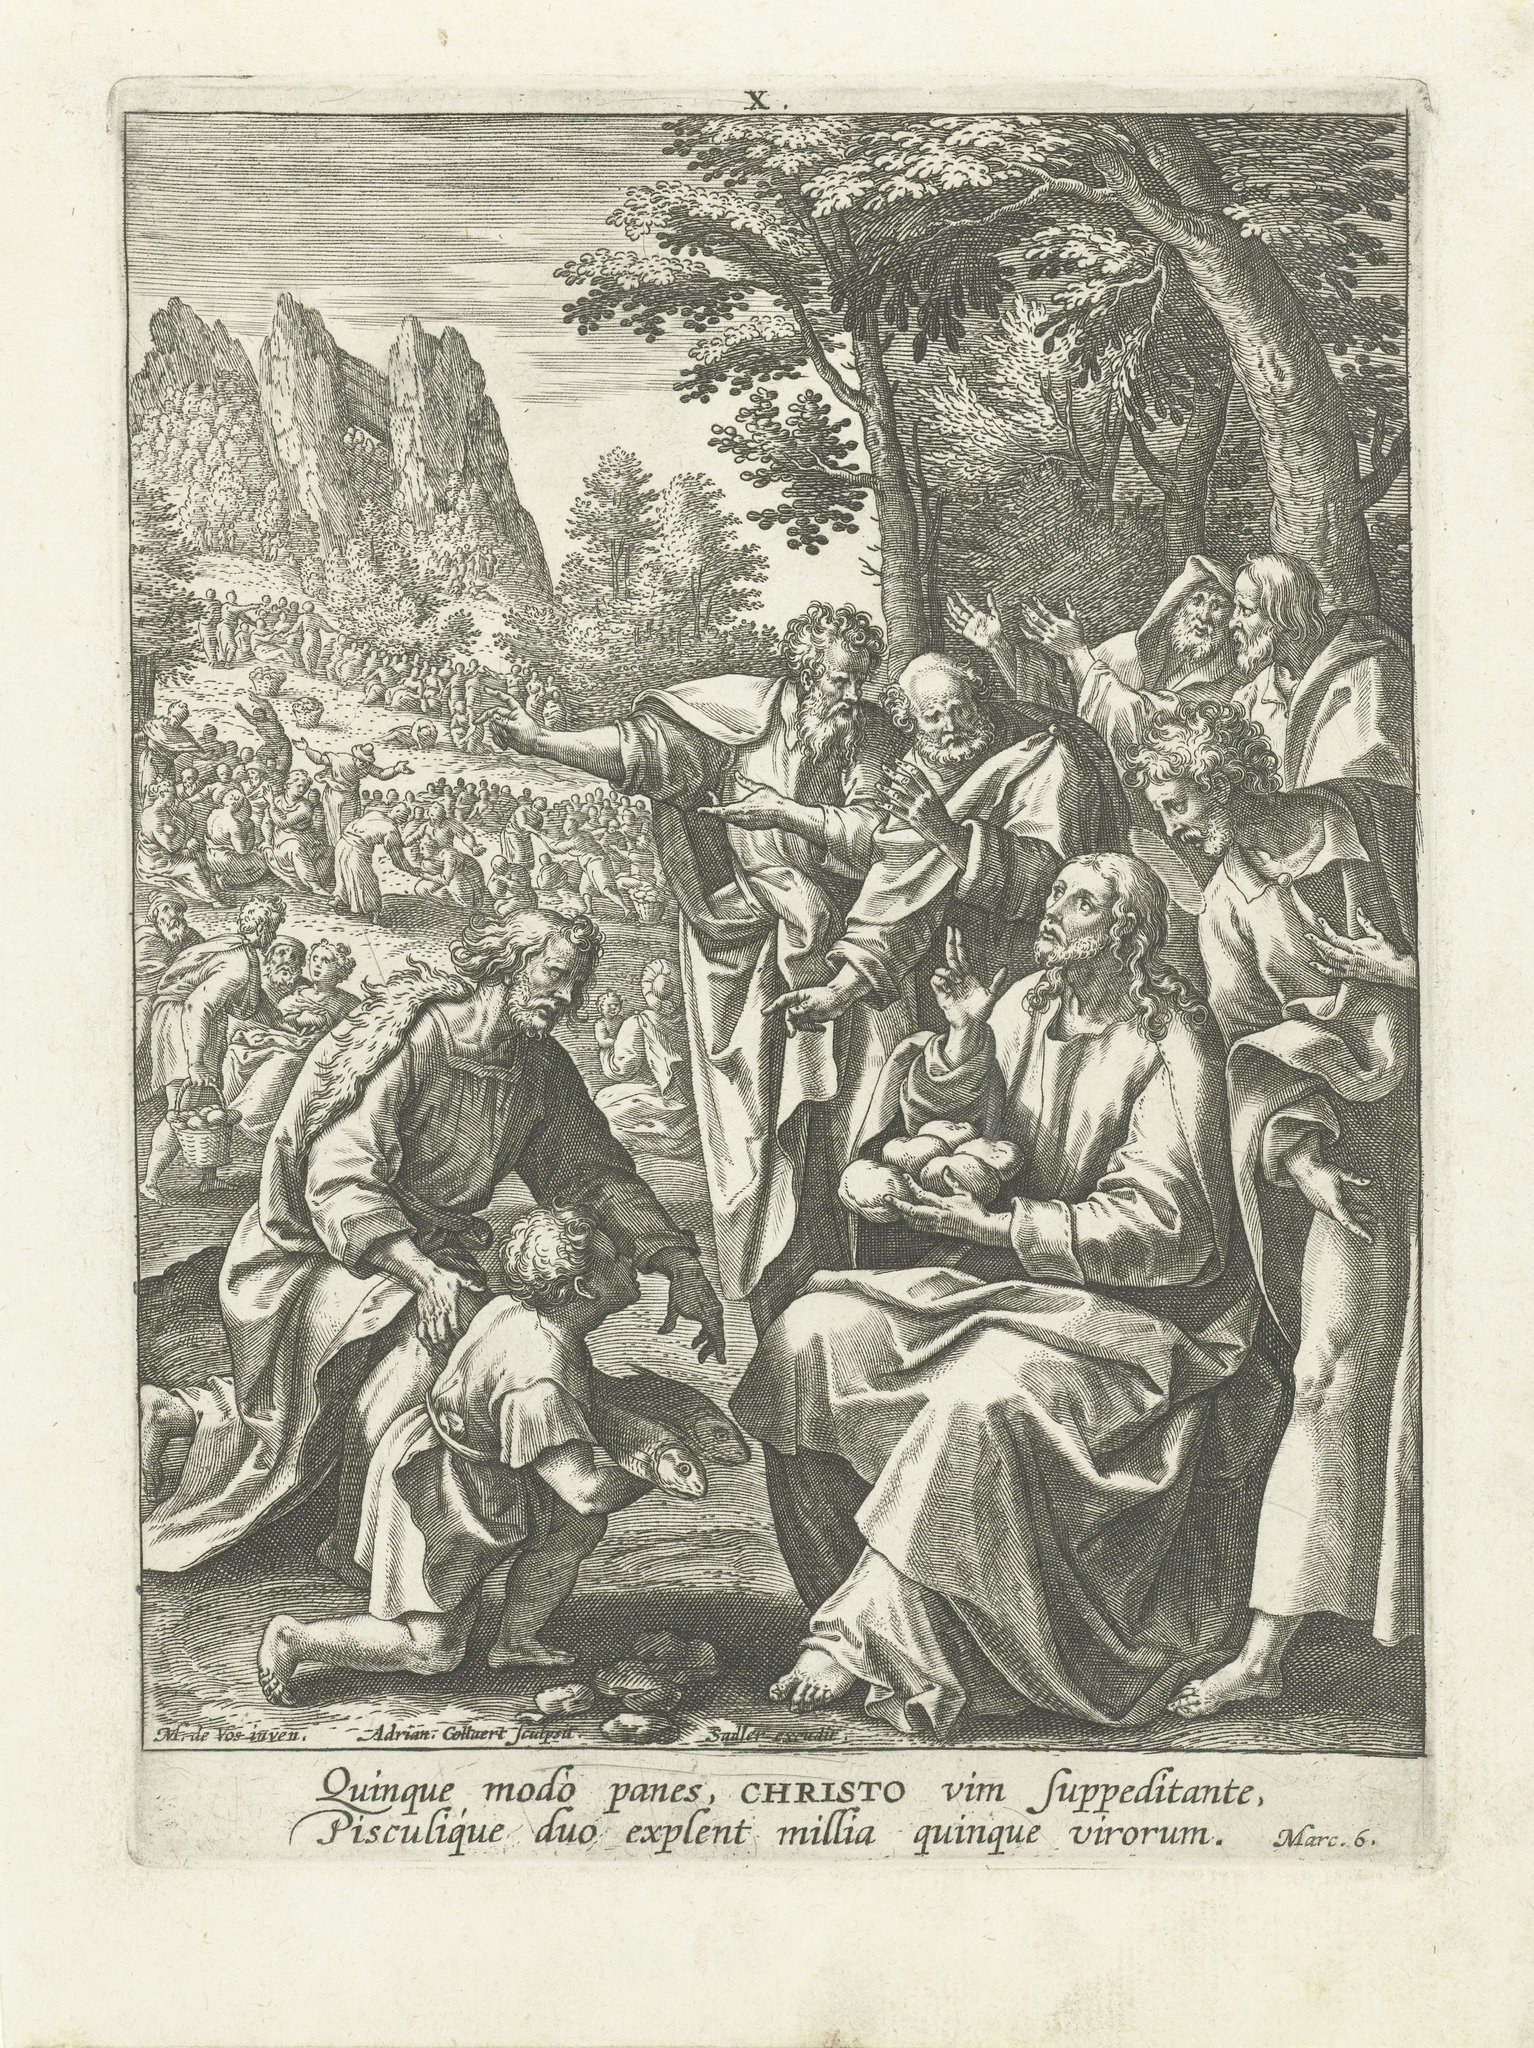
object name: print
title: Vita I. Christi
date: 1583-1588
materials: paper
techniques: engraving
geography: antwerp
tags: christ blessing the bread and fish brought by a boy, christ and apostles distribute bread and fish among the multitude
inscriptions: collector's mark: Lugt 2228, collector's mark: Lugt 2760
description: Christus en zijn apostelen zitten samen. Achter hen zijn er heel wat mensen bij elkaar gekomen om Christus te horen spreken. De apostelen hebben niet genoeg brood mee voor deze luisteraars. Christus zegent de zeven broden en twee vissen die een kind aanbrengt en iedereen kon eten (Marcus 6:32-44). De prent heeft een Latijns onderschrift. De prent maakt deel uit van een serie over het leven van Christus.